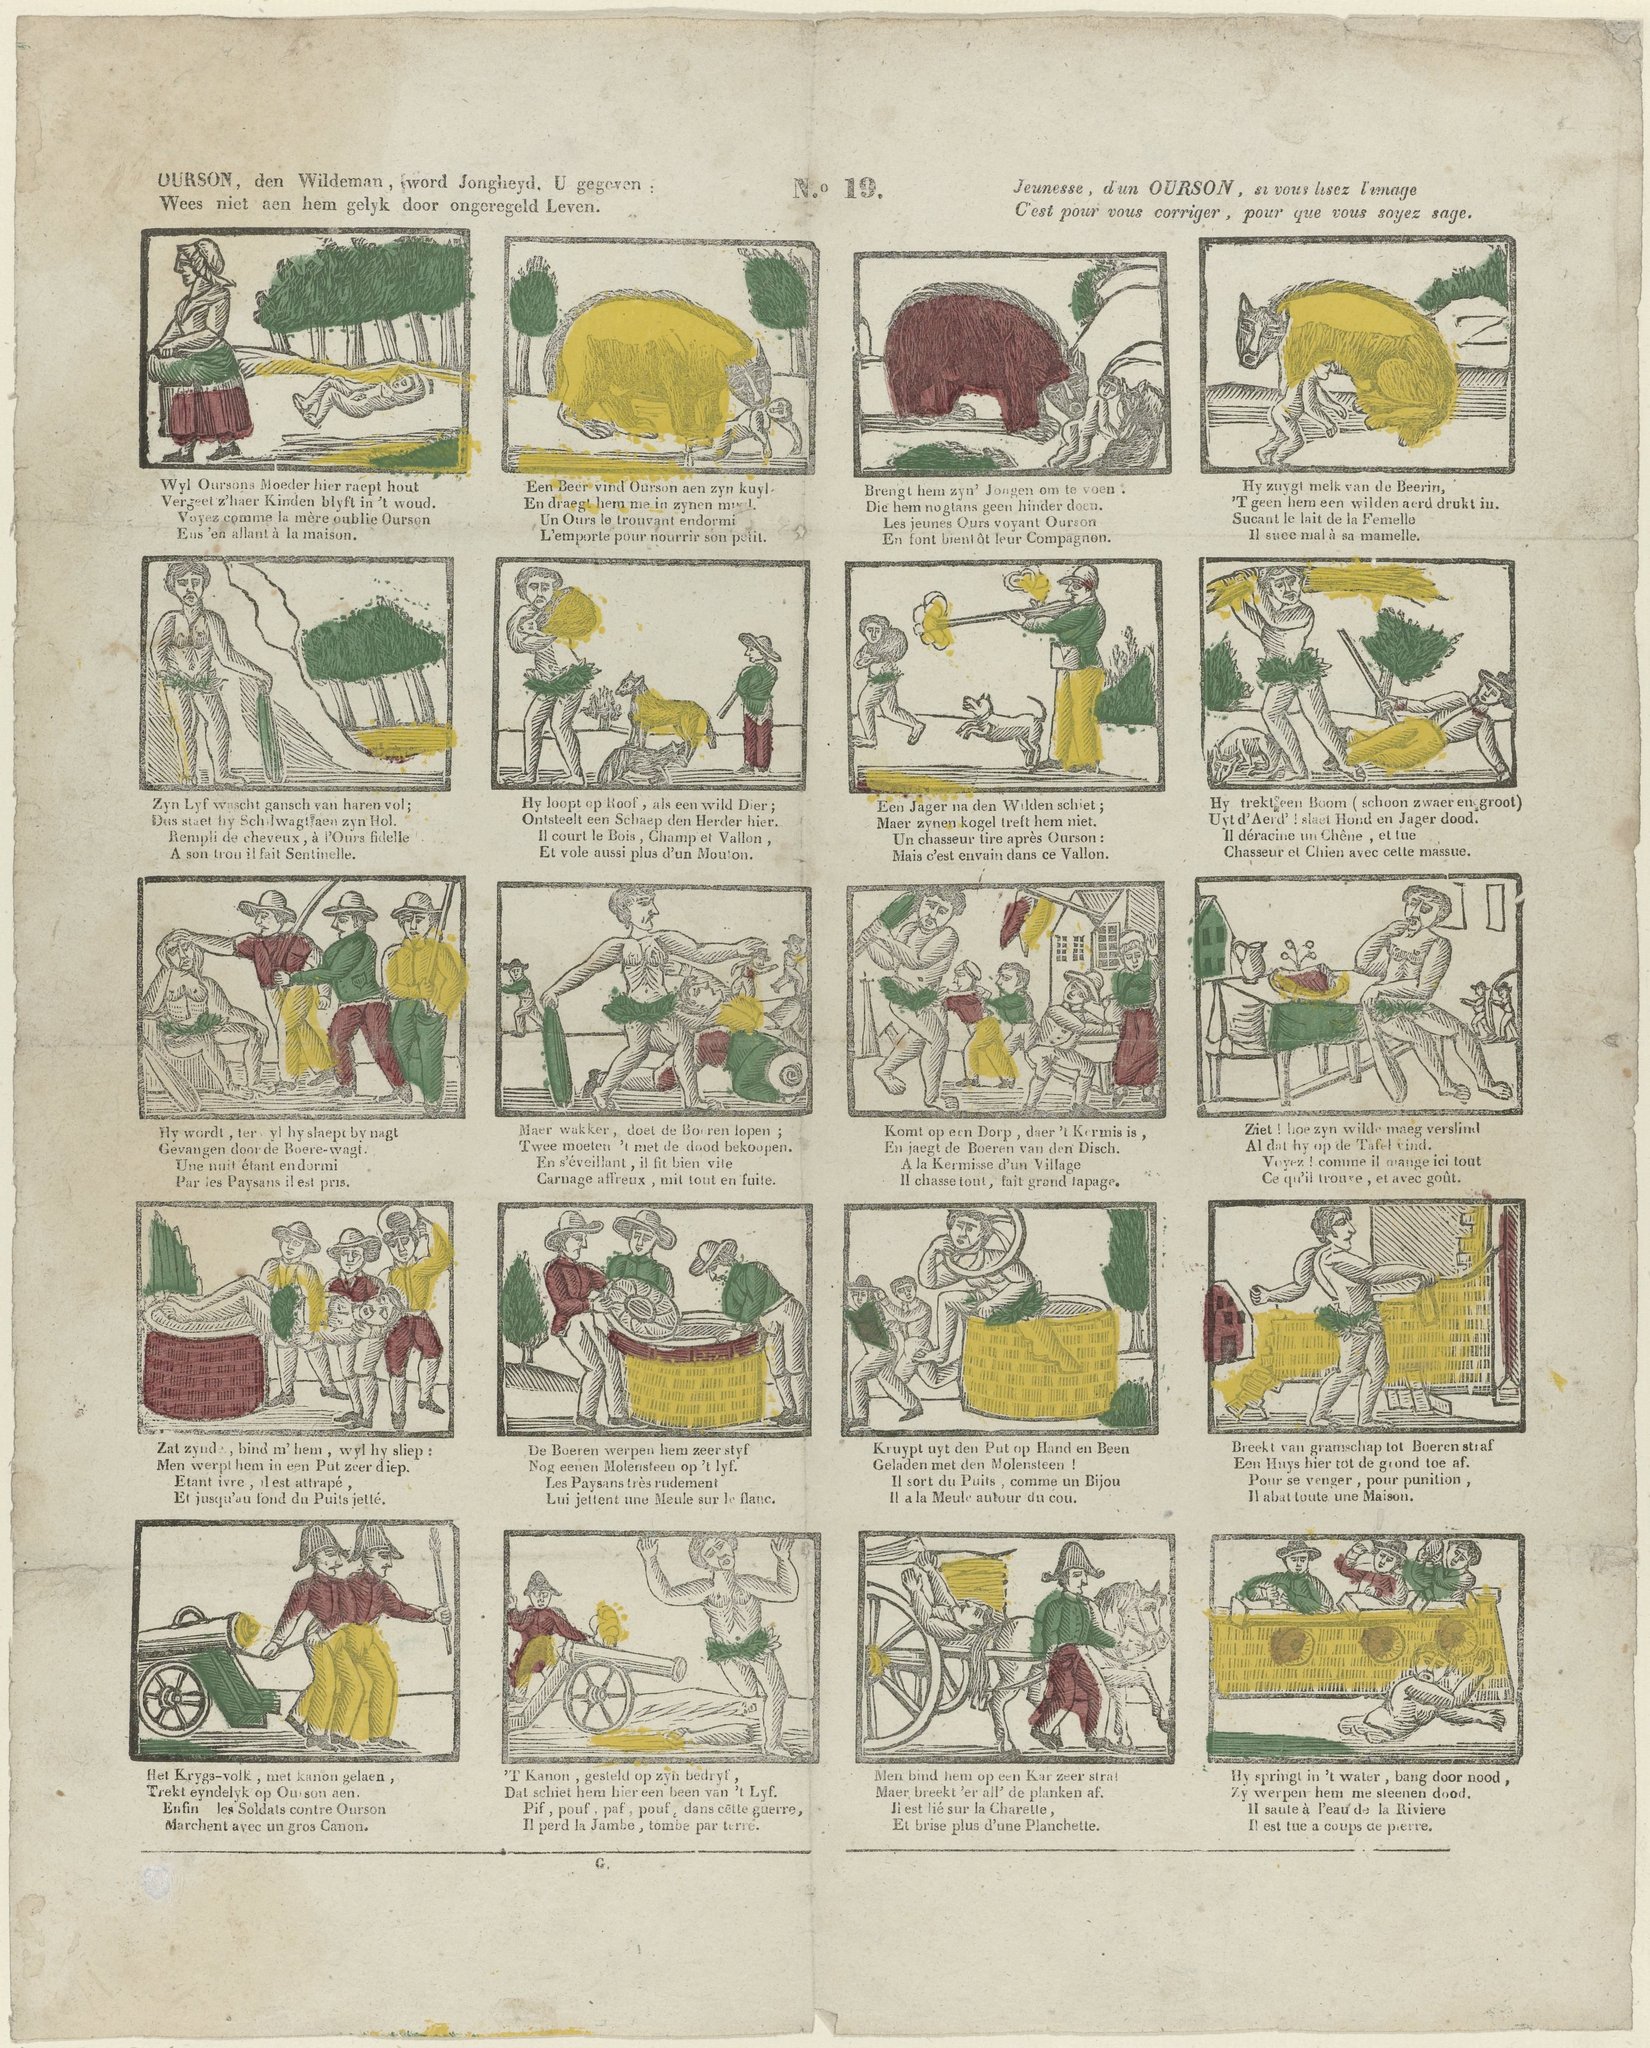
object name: popular print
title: Ourson, den wildeman, word jongheyd, u gegeven: / Wees niet aen hem gelyk door ongeregeld leven / Jeunesse, d'un Ourson, si vous lisez l'image / C'est pour vous corriger, pour que vous soyez sage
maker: Anonymous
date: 1833-1856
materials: paper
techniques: colour, letterpress printing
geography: turnhout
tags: man and (wild) animal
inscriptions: collector's mark: Lugt 2760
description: Blad met 20 voorstellingen over het leven van Ourson, een jongen die opgroeit in de wildernis. Onder elke afbeelding een tweeregelig vers in het Nederlands en in het Frans. Genummerd midden boven: No. 19.